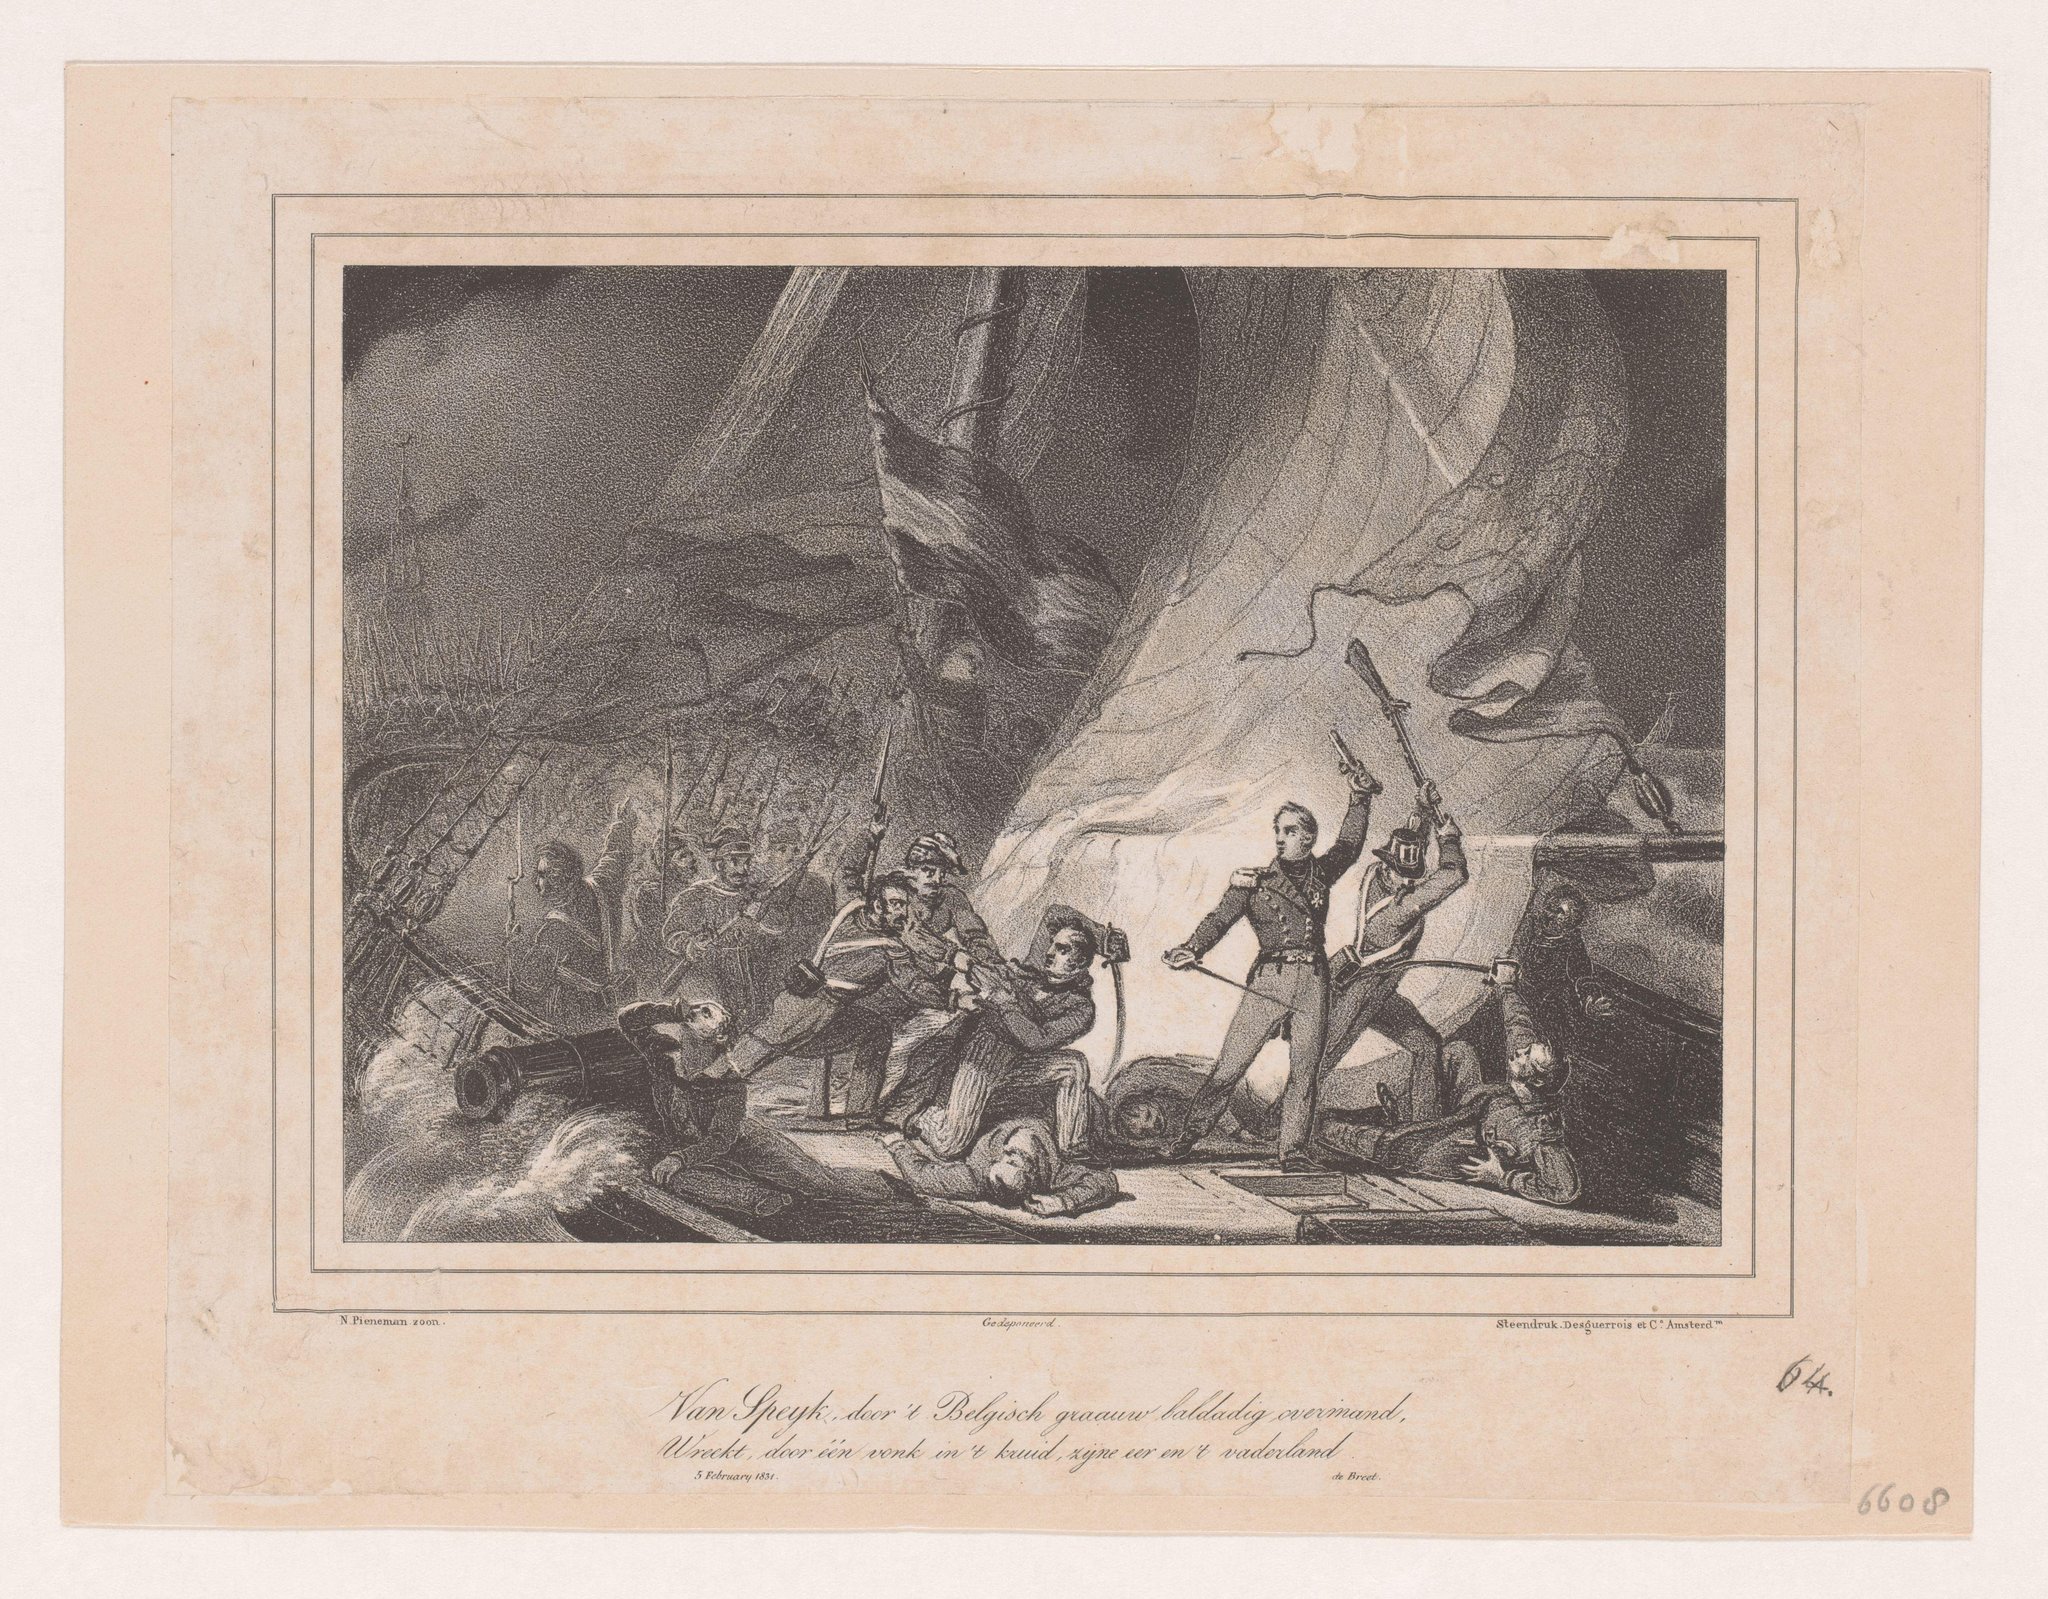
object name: print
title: Van Speyk brengt zijn boot tot ontploffing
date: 1831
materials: paper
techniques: lithograph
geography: amsterdam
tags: amsterdam, antwerp, jan van speyk, projectiles, explosives, etc. (+ naval force), manual signalling with flags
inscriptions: collector's mark: Lugt 2228, : ‘Gedeponeerd.’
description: Belgische soldaten zijn aan boord van de boot geklommen en overmeesteren de Nederlandse soldaten. Rechts van het midden staat Van Speyk met zijn linkerhand in de lucht, klaar om de boot tot ontploffing te brengen. Links bij een kanon ligt een soldaat met zijn ogen op de hemel gericht. In het midden zwaait een soldaat met de Nederlandse vlag.